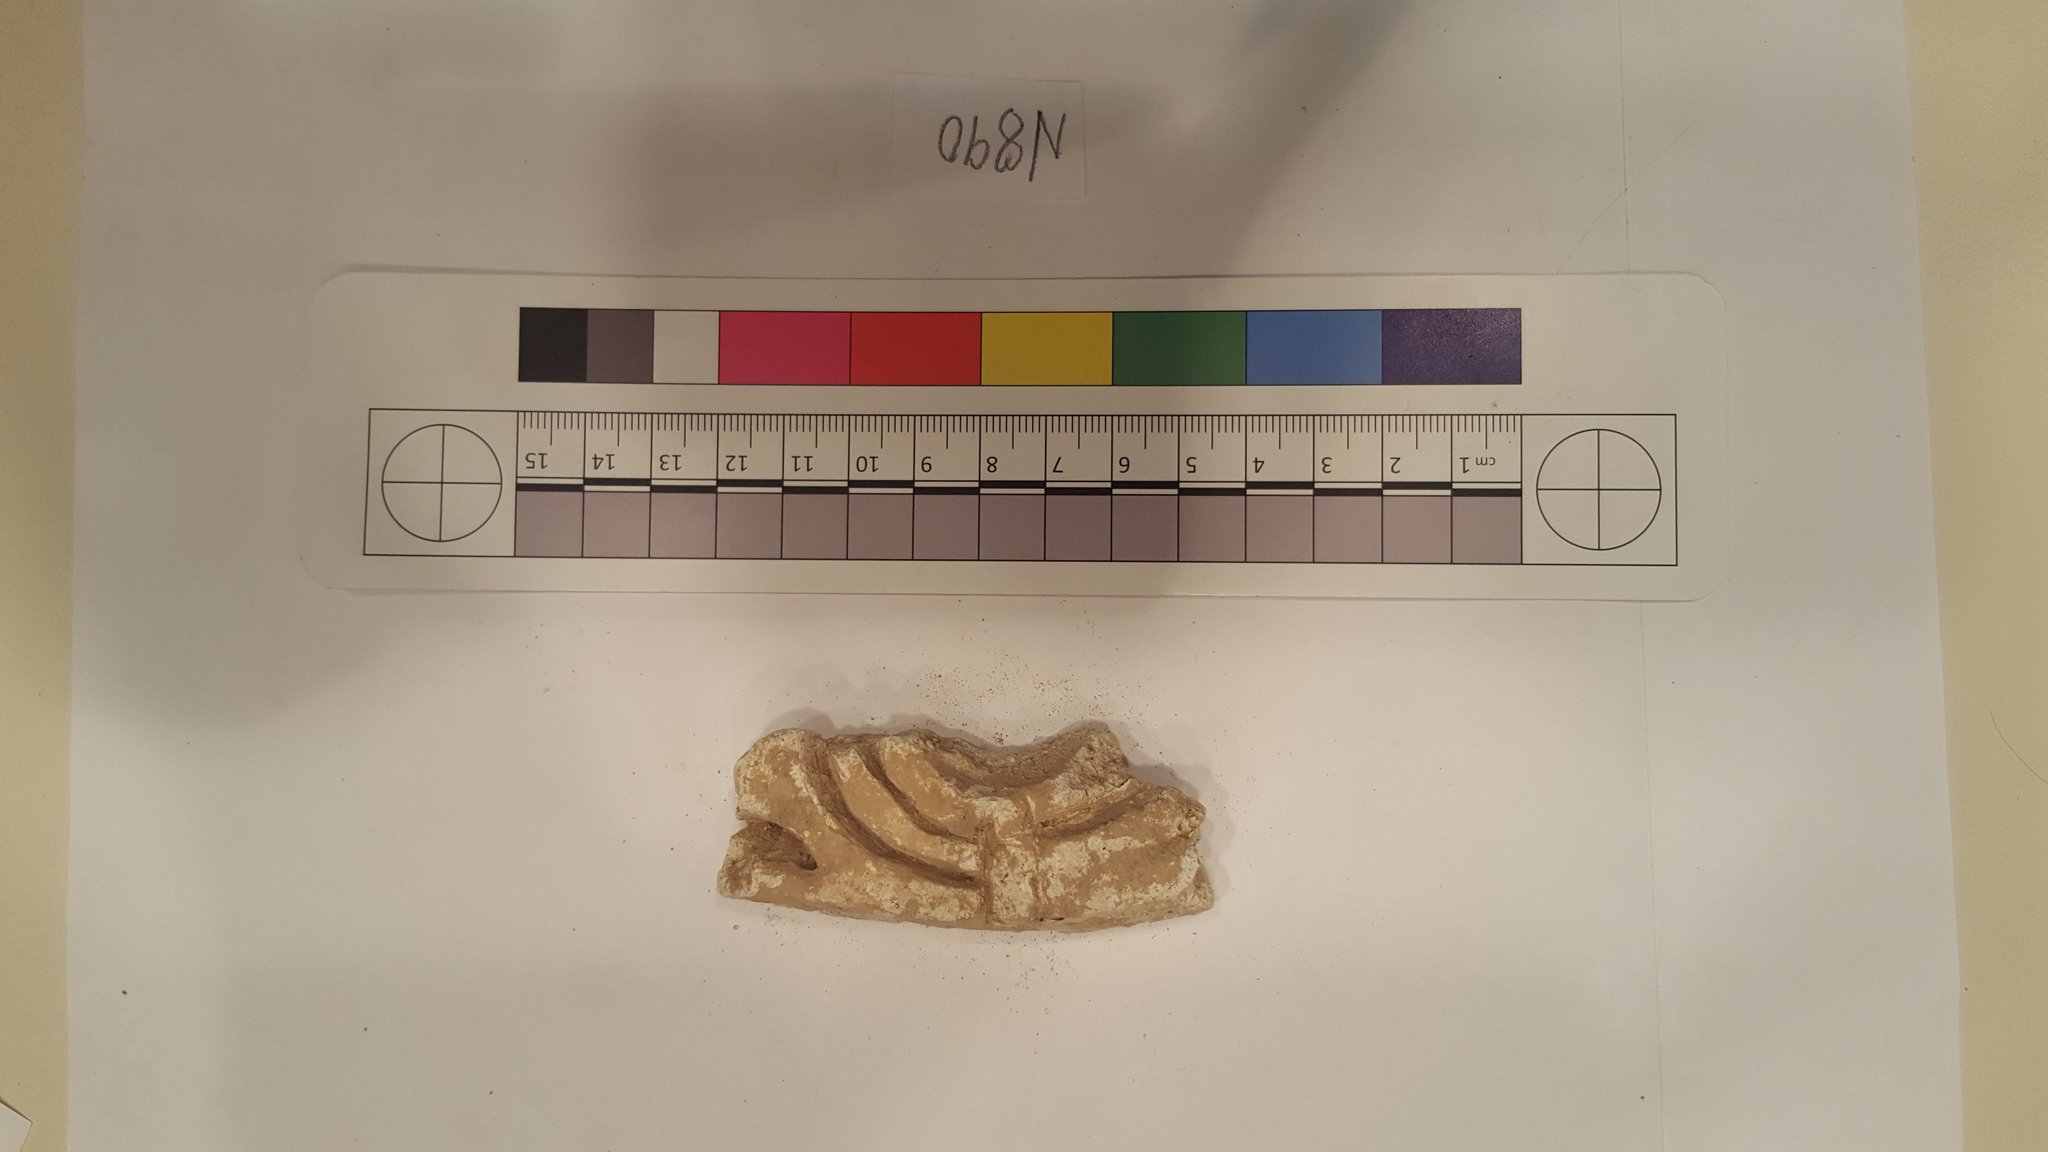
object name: fragment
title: Stucco Fragment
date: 701-1200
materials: plaster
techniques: carving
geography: iran